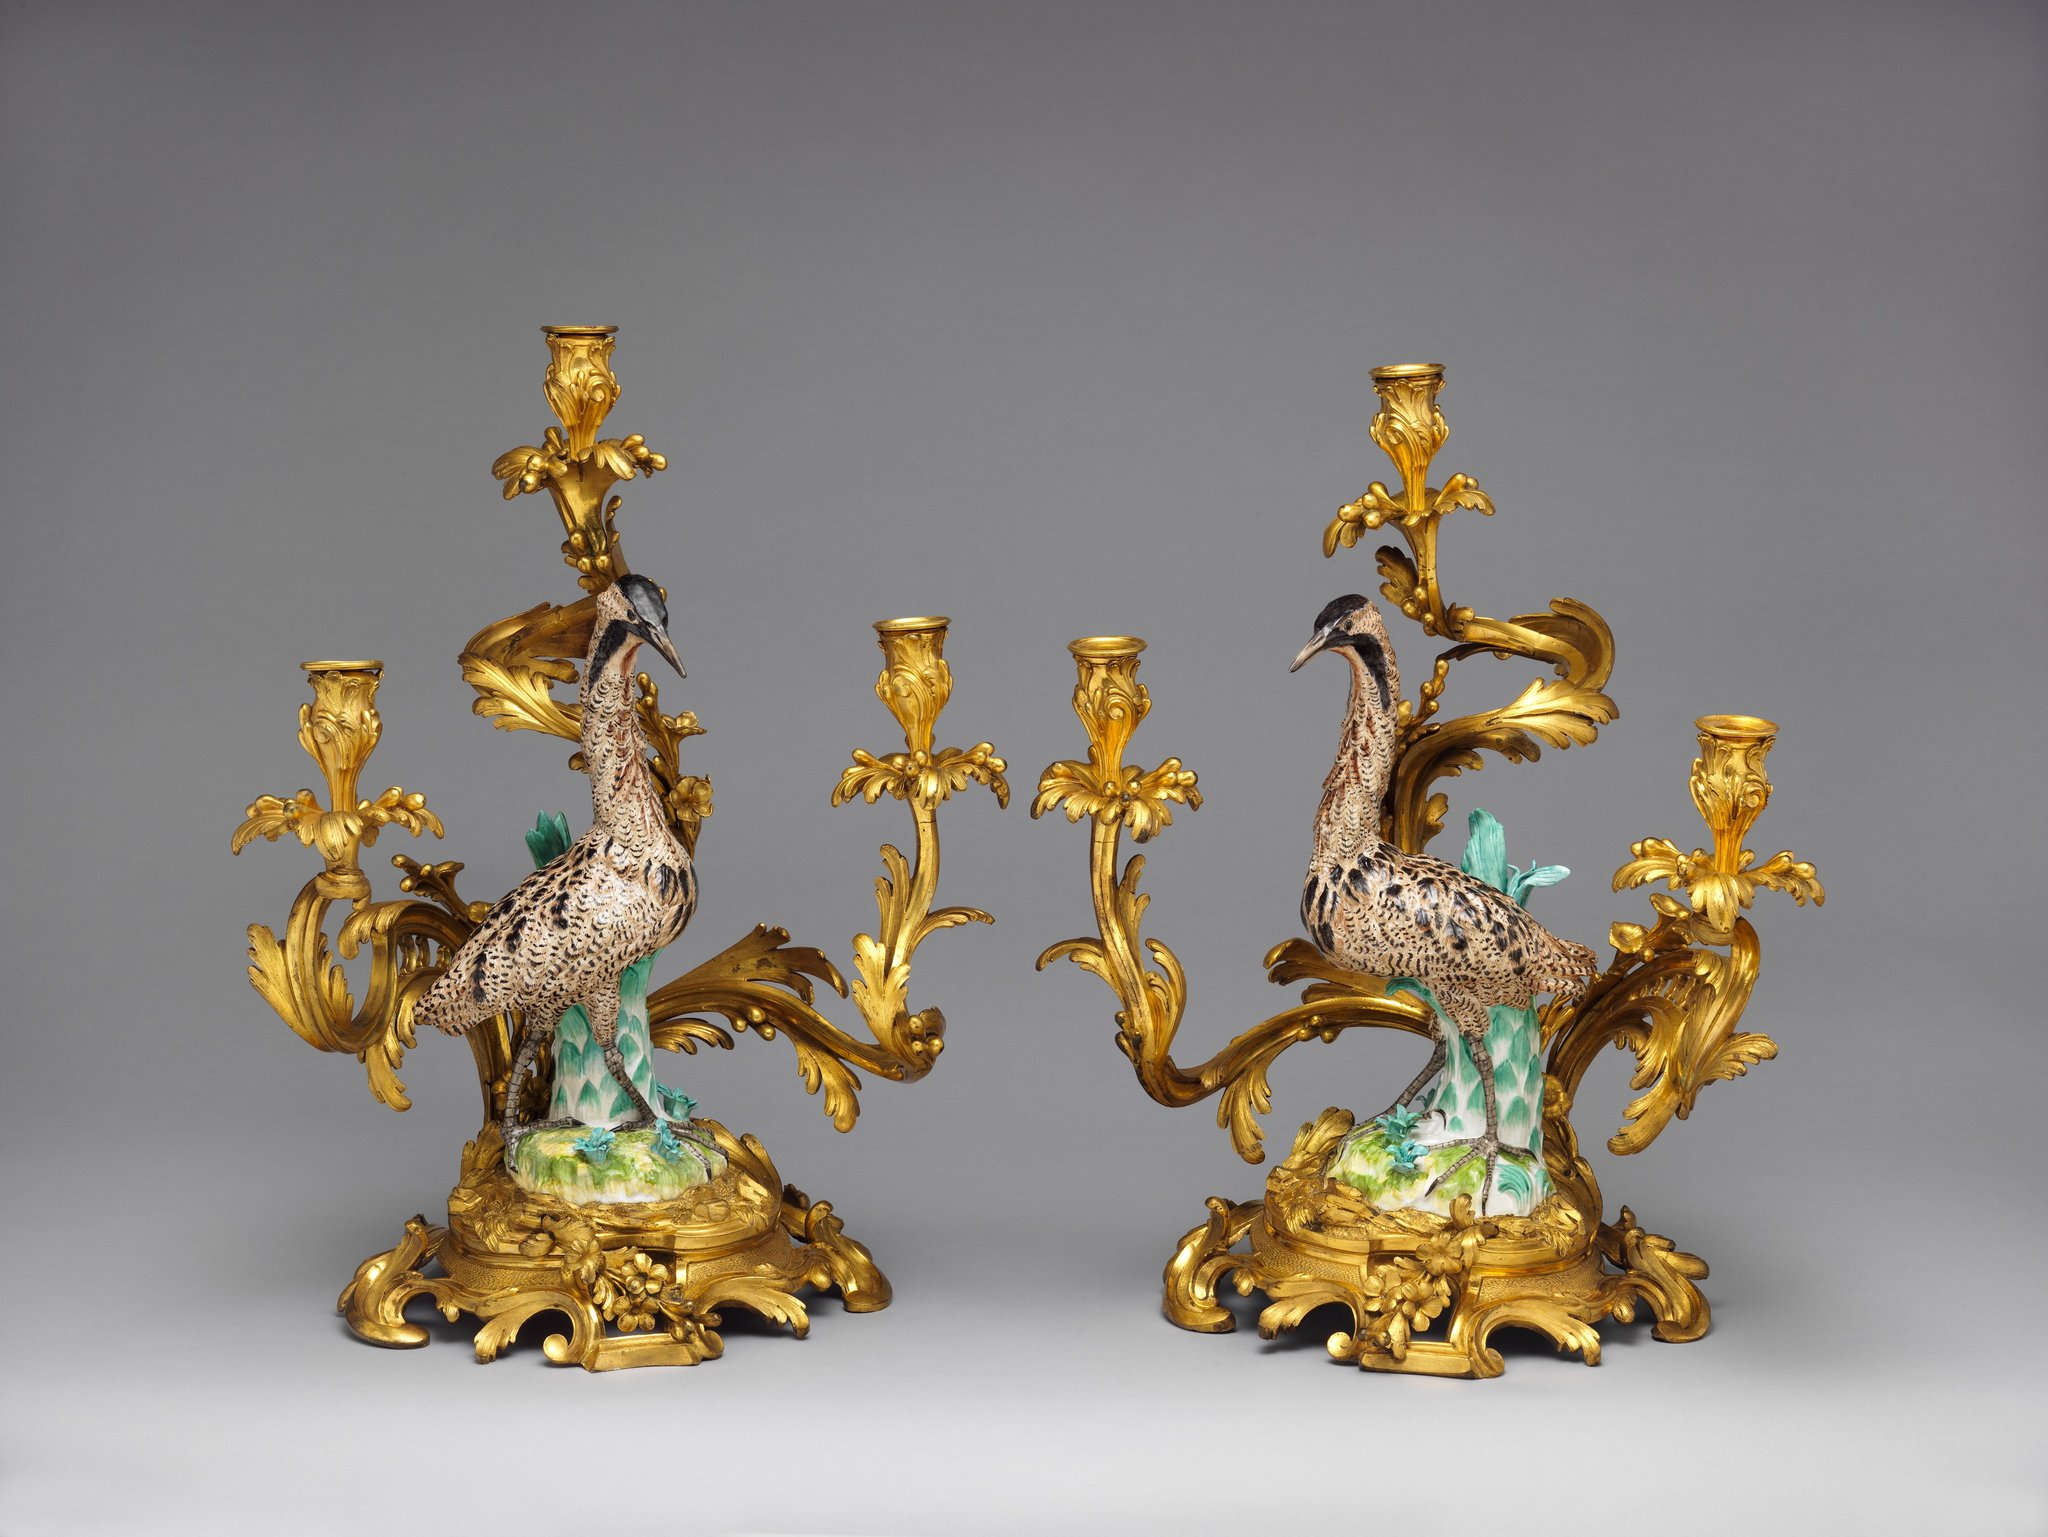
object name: candelabrum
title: Three-light candelabra (candélabre or girandole) (one of a pair)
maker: johann joachim kändler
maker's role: modeler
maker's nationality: german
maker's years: 1706-1775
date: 1750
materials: gilt bronze, hard paste porcelain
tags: birds